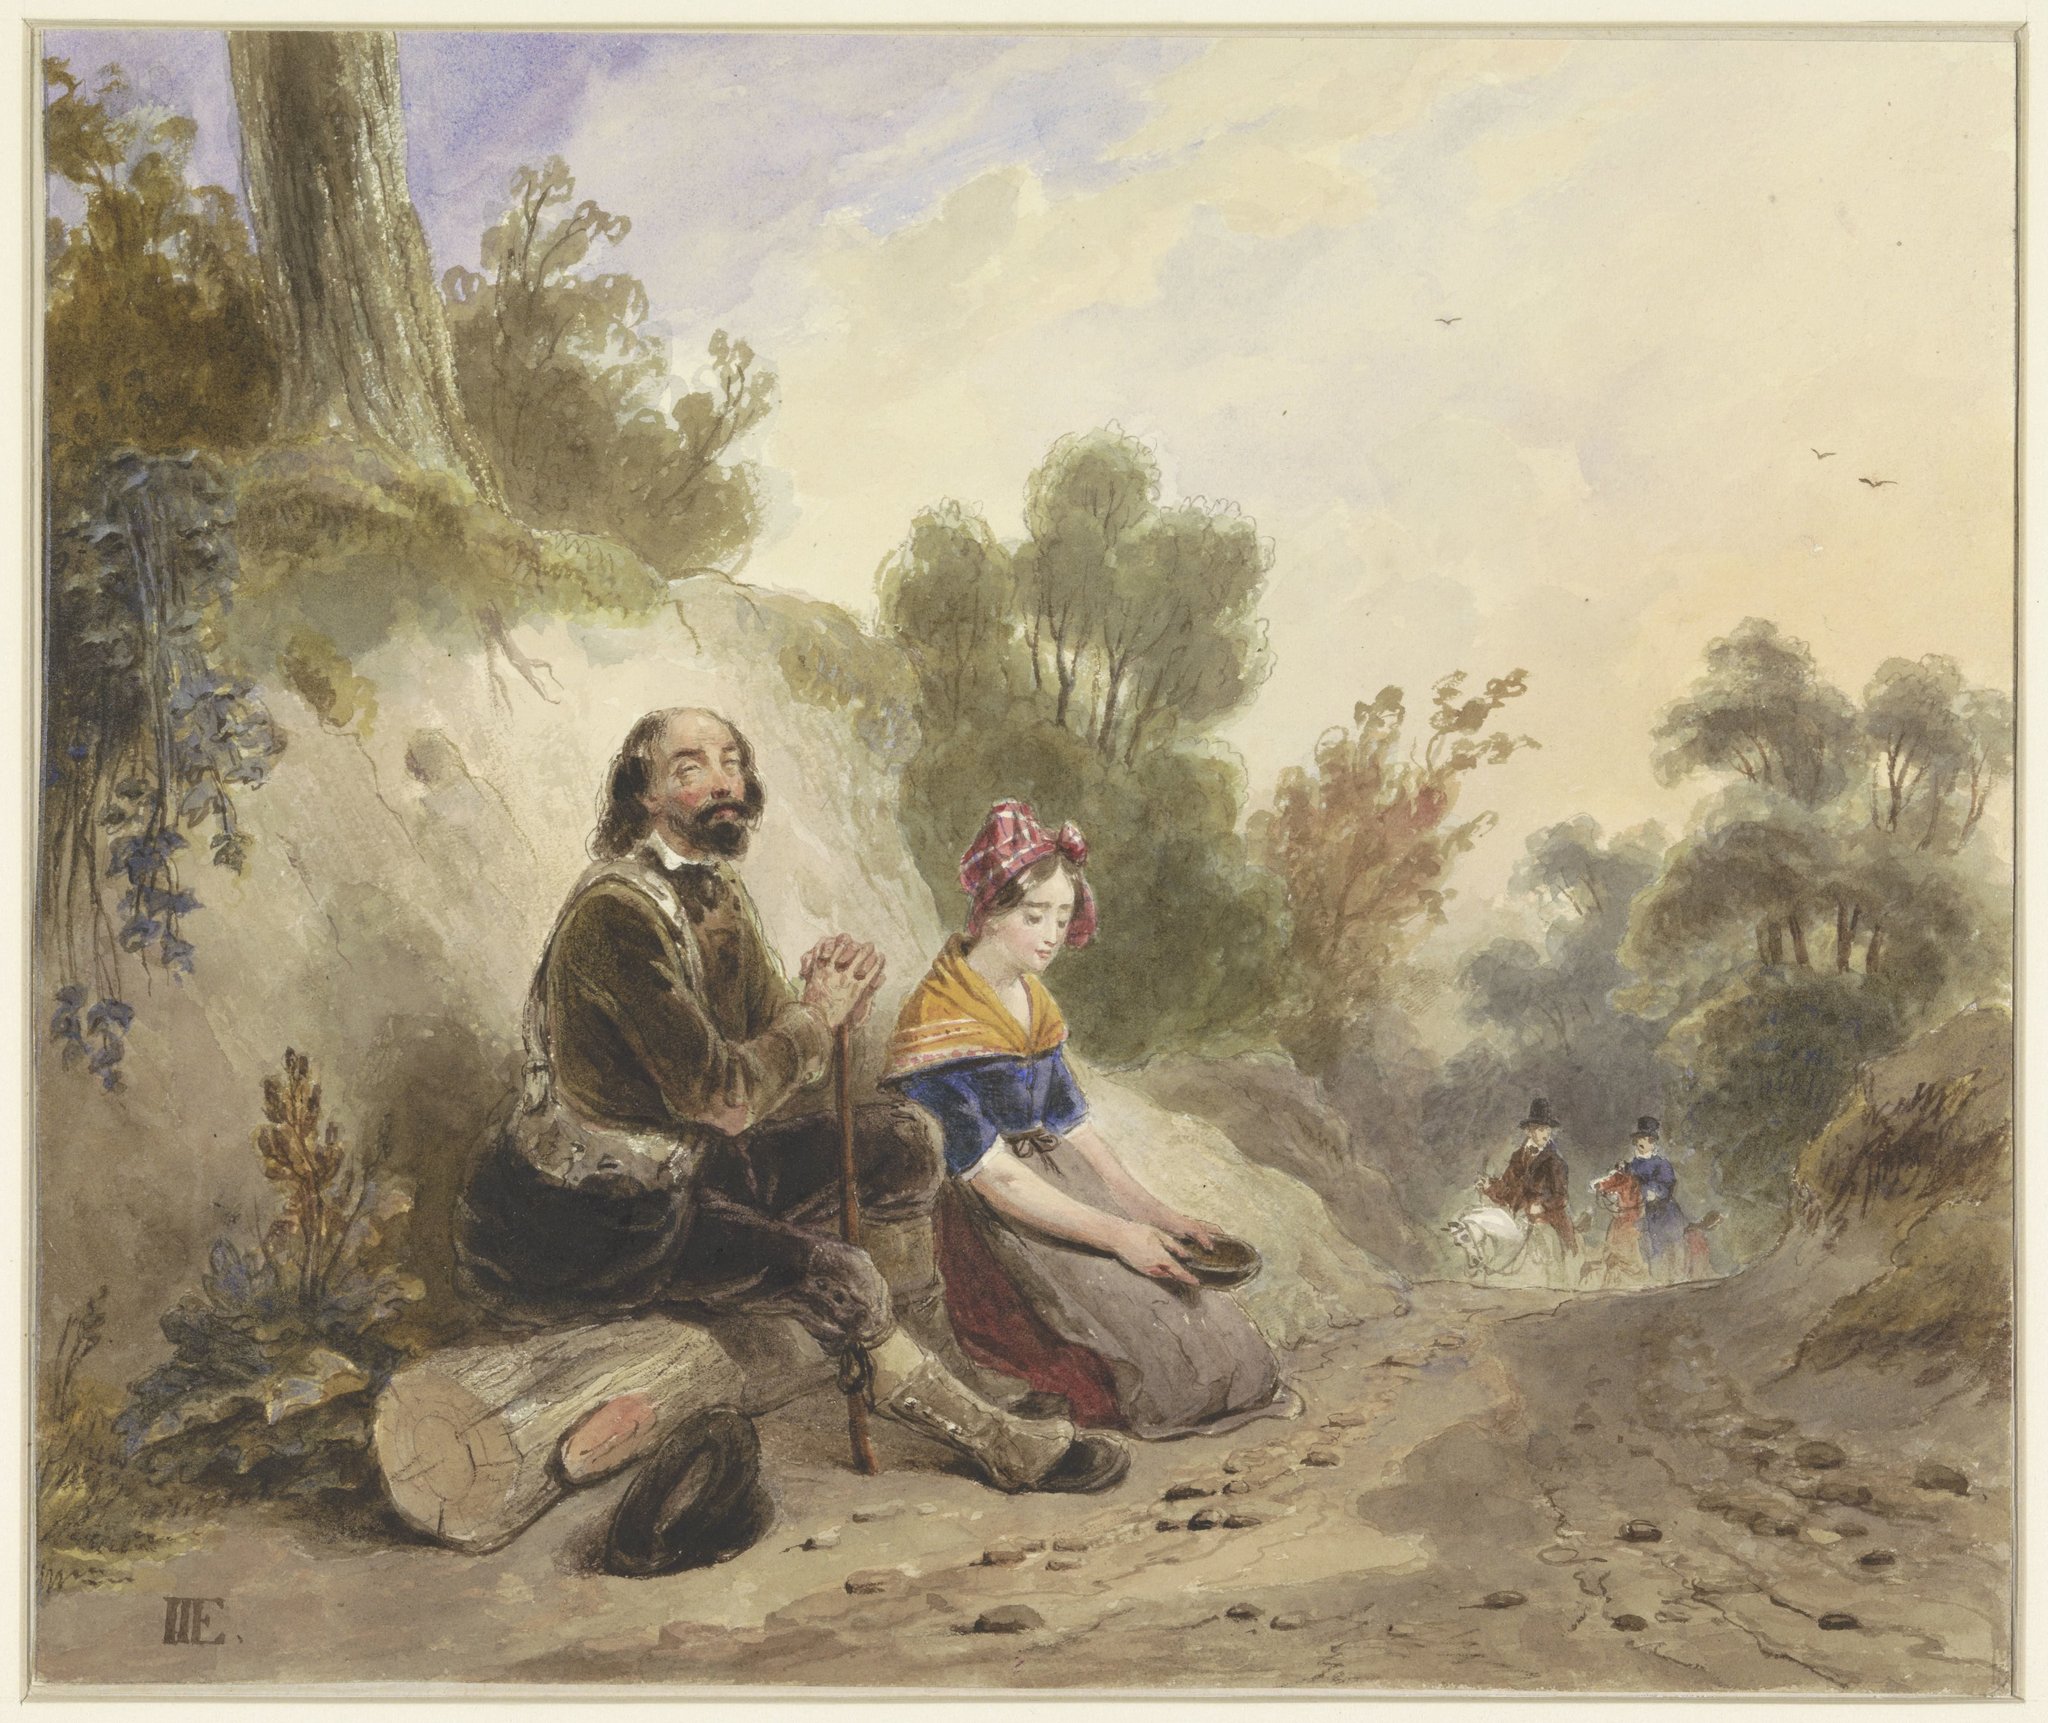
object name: drawing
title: Blinde man met meisje, bedelend aan de kant van een landweg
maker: jacob joseph eeckhout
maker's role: draughtsman, print maker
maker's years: 1793-1861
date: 1803-1861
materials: paper, watercolor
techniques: brush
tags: blind, blindness, beggar